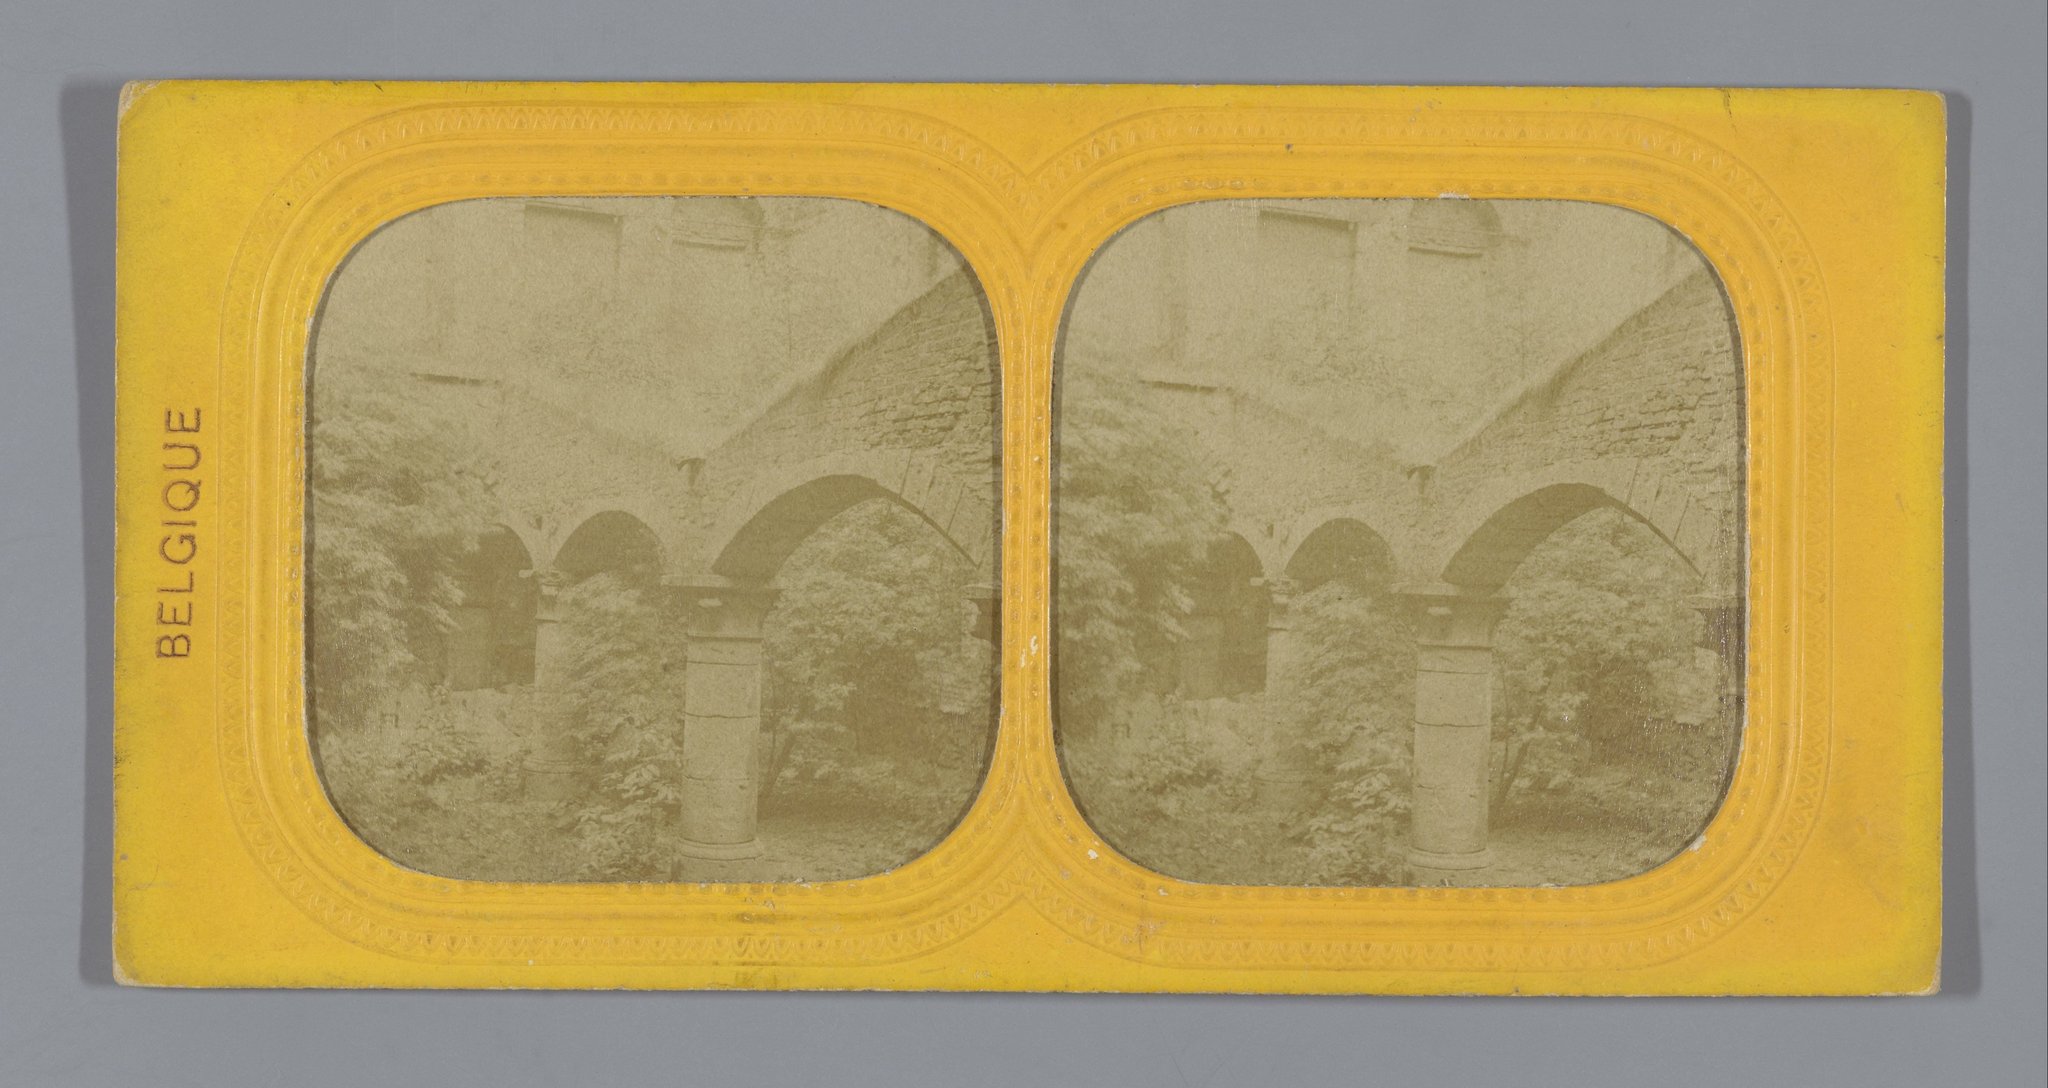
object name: tissue stereograph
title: Belgique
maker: Anonymous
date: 1865-1875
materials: cardboard, paper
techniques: albumen print, hand coloring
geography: spa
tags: spring, source of river or stream